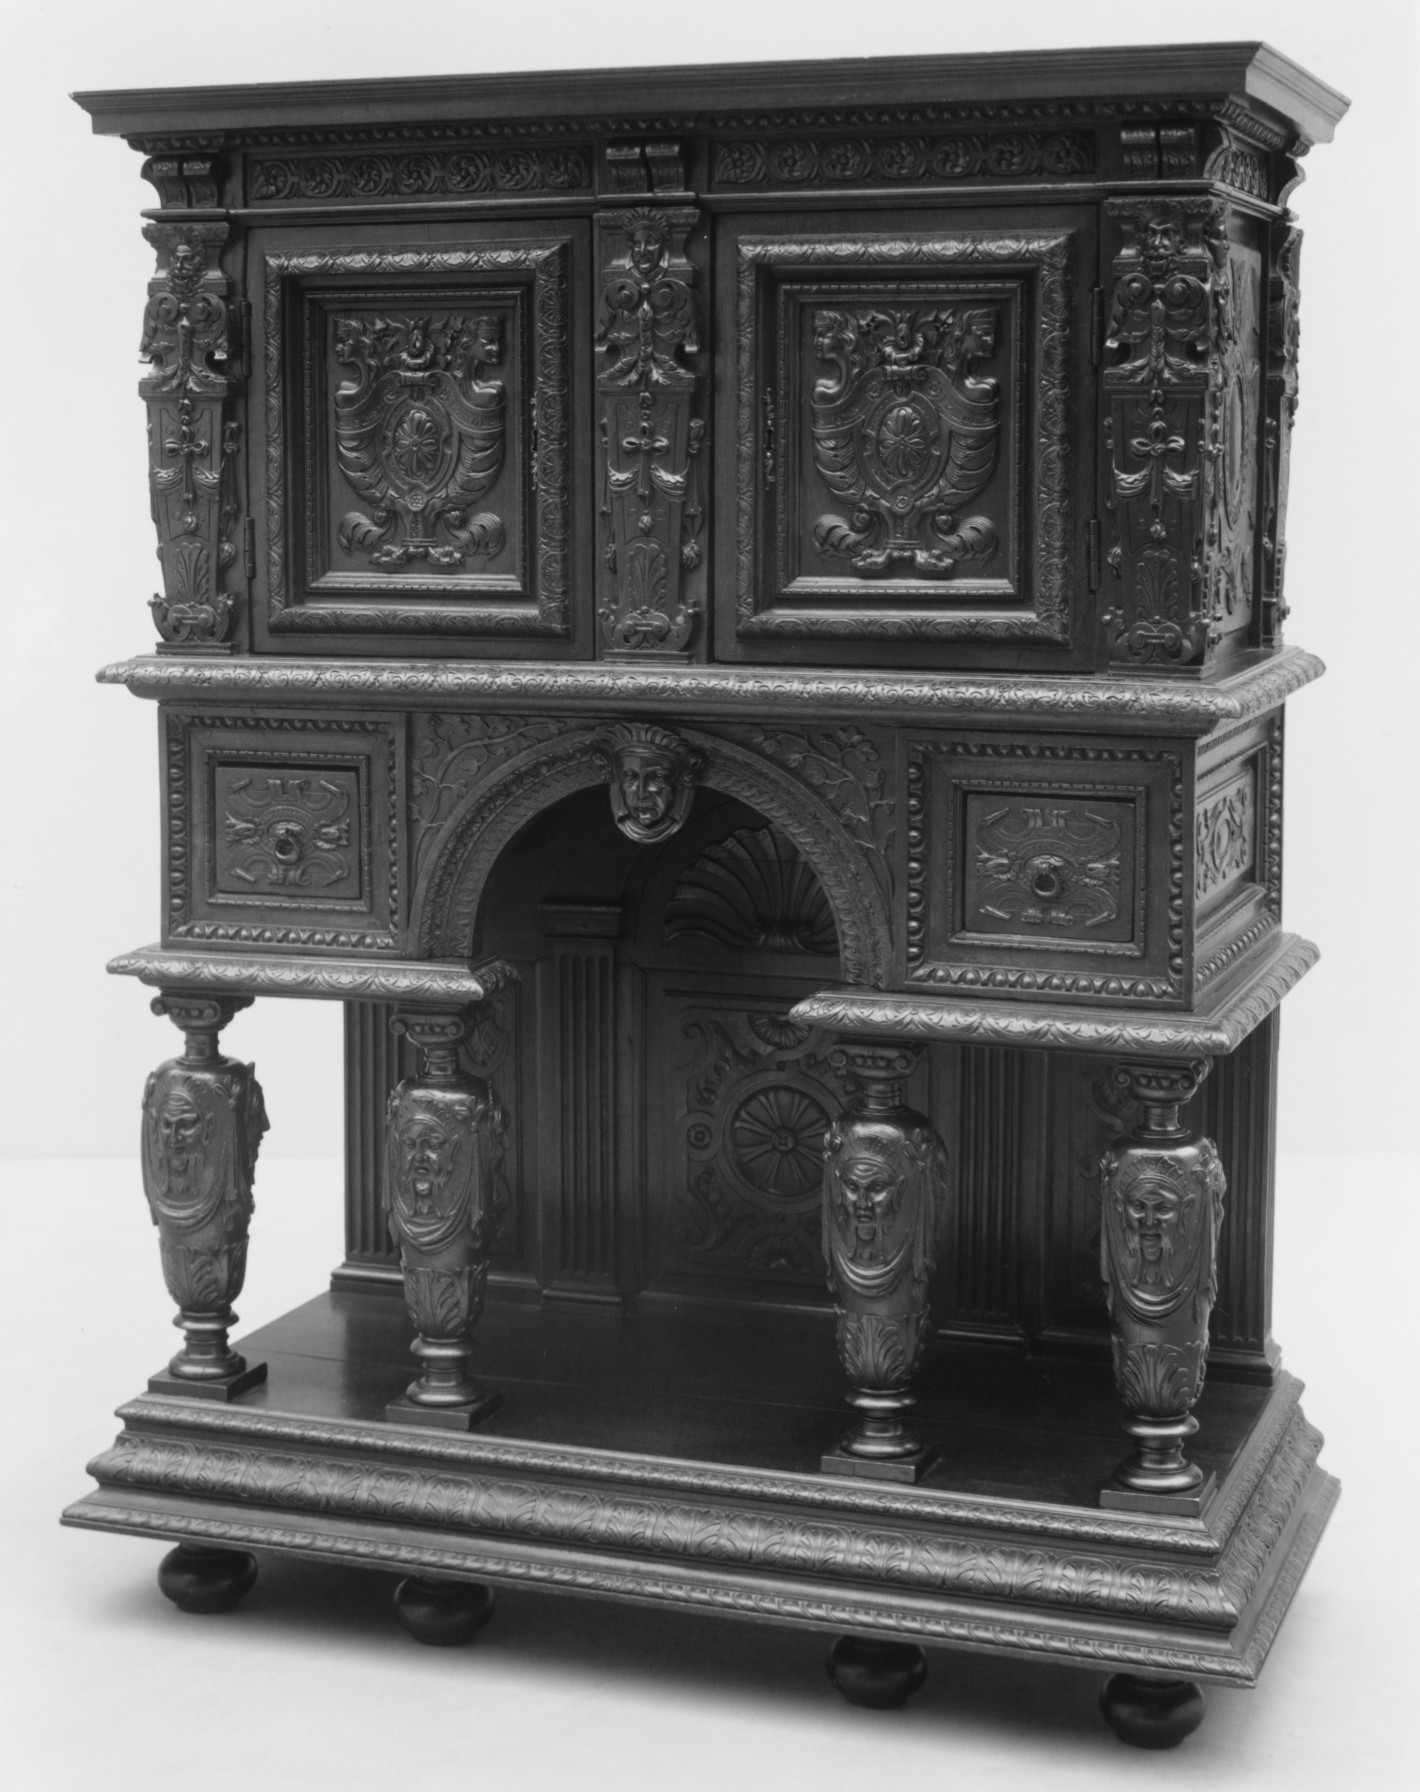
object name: cabinet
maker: hugues sambin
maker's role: artist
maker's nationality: french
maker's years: 1520-1601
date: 1801-1900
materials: wood